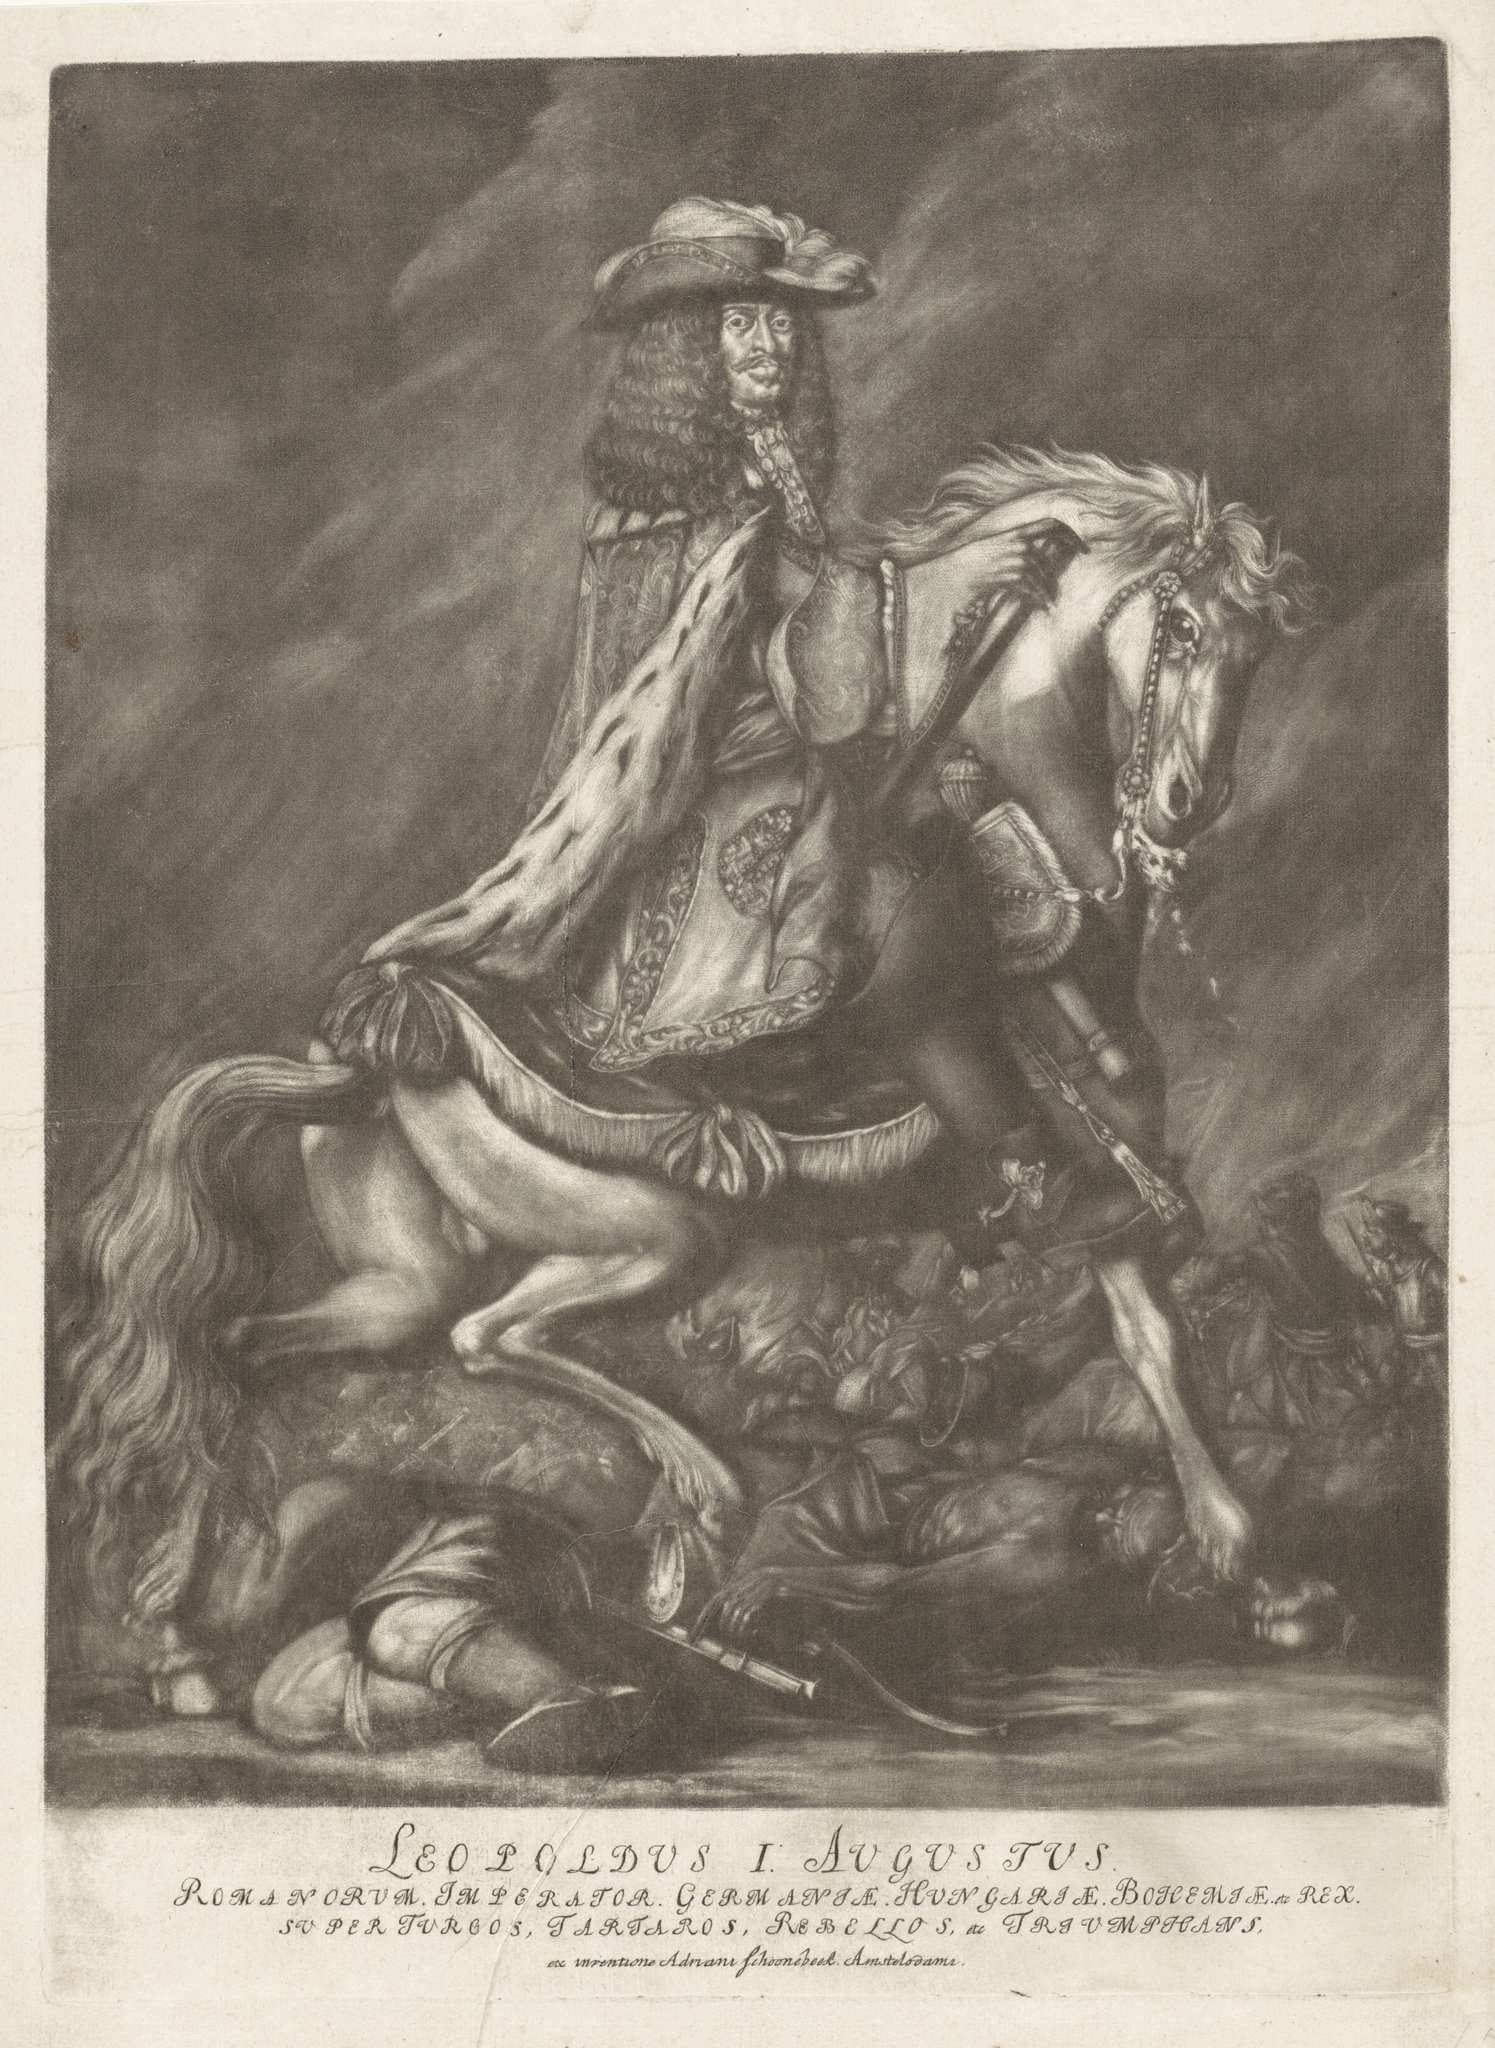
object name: print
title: Ruiterportret van keizer Leopold I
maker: adriaen schoonebeek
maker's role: print maker, publisher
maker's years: 1661-1705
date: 1670-1714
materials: paper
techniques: mezzotint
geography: amsterdam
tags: vienna, leopold i (keizer van duitsland), horse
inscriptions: collector's mark: Lugt 2228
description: Portret van Leopold I, keizer van het Heilig Roomse Rijk, aartshertog van Oostenrijk en koning van Hongarije. De prent heeft een Latijns onderschrift met de naam en de titels van de geportretteerde.